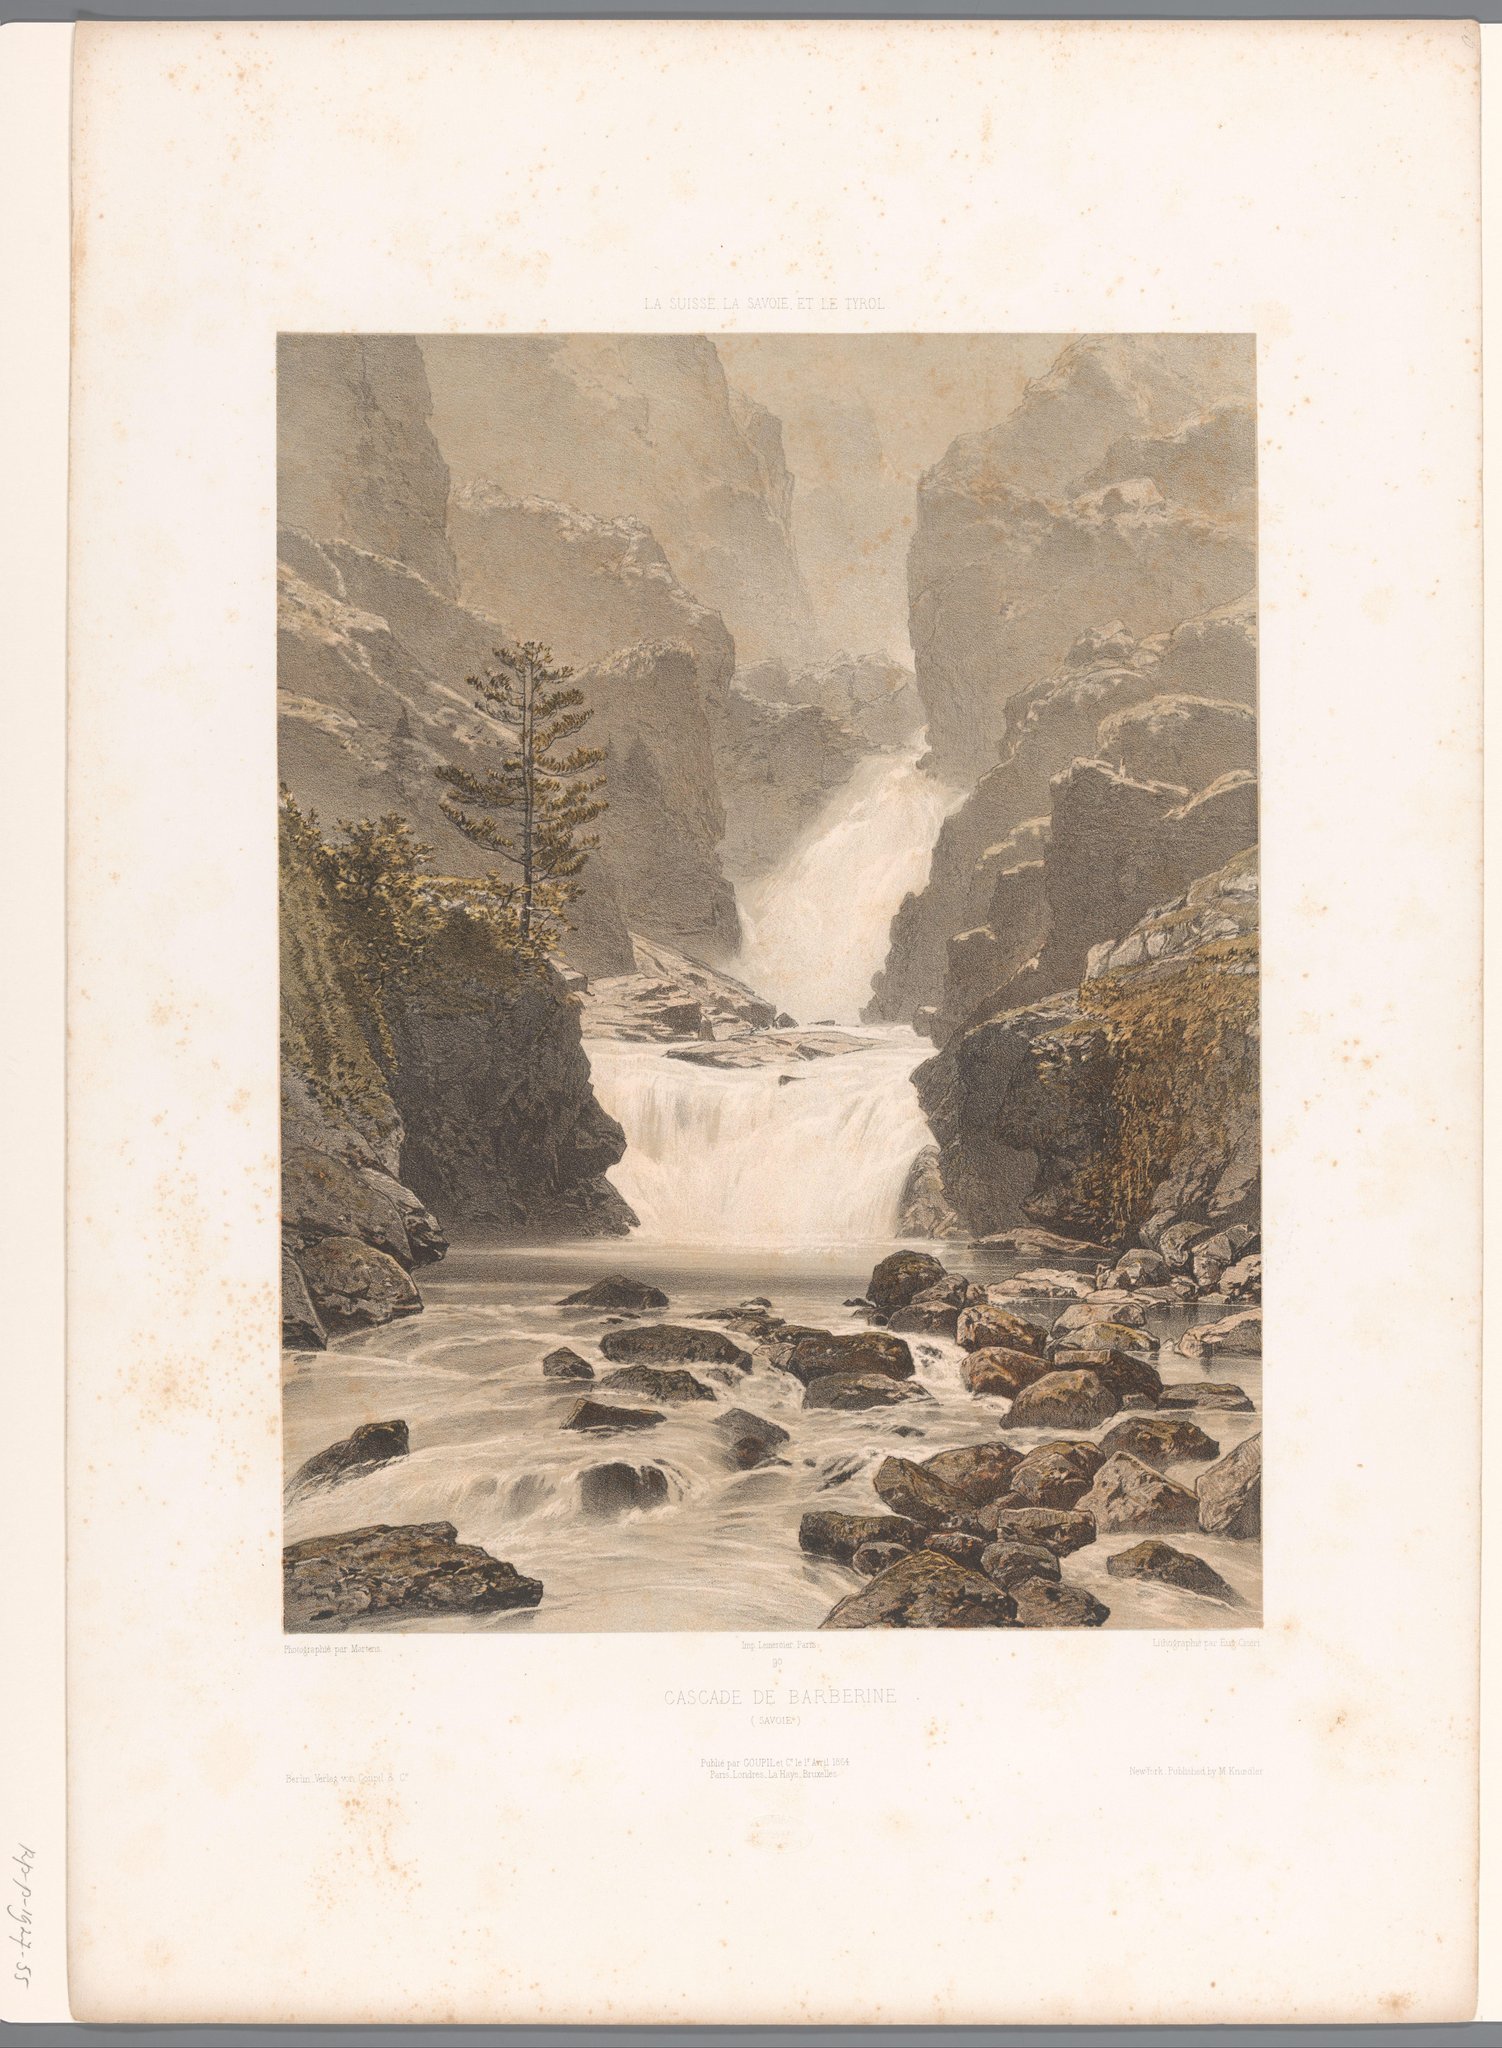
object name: print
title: La Suisse, la Savoie et le Tyrol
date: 1859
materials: paper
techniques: lithograph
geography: paris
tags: waterfall, rock-formations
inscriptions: check stamp: Lugt 1090